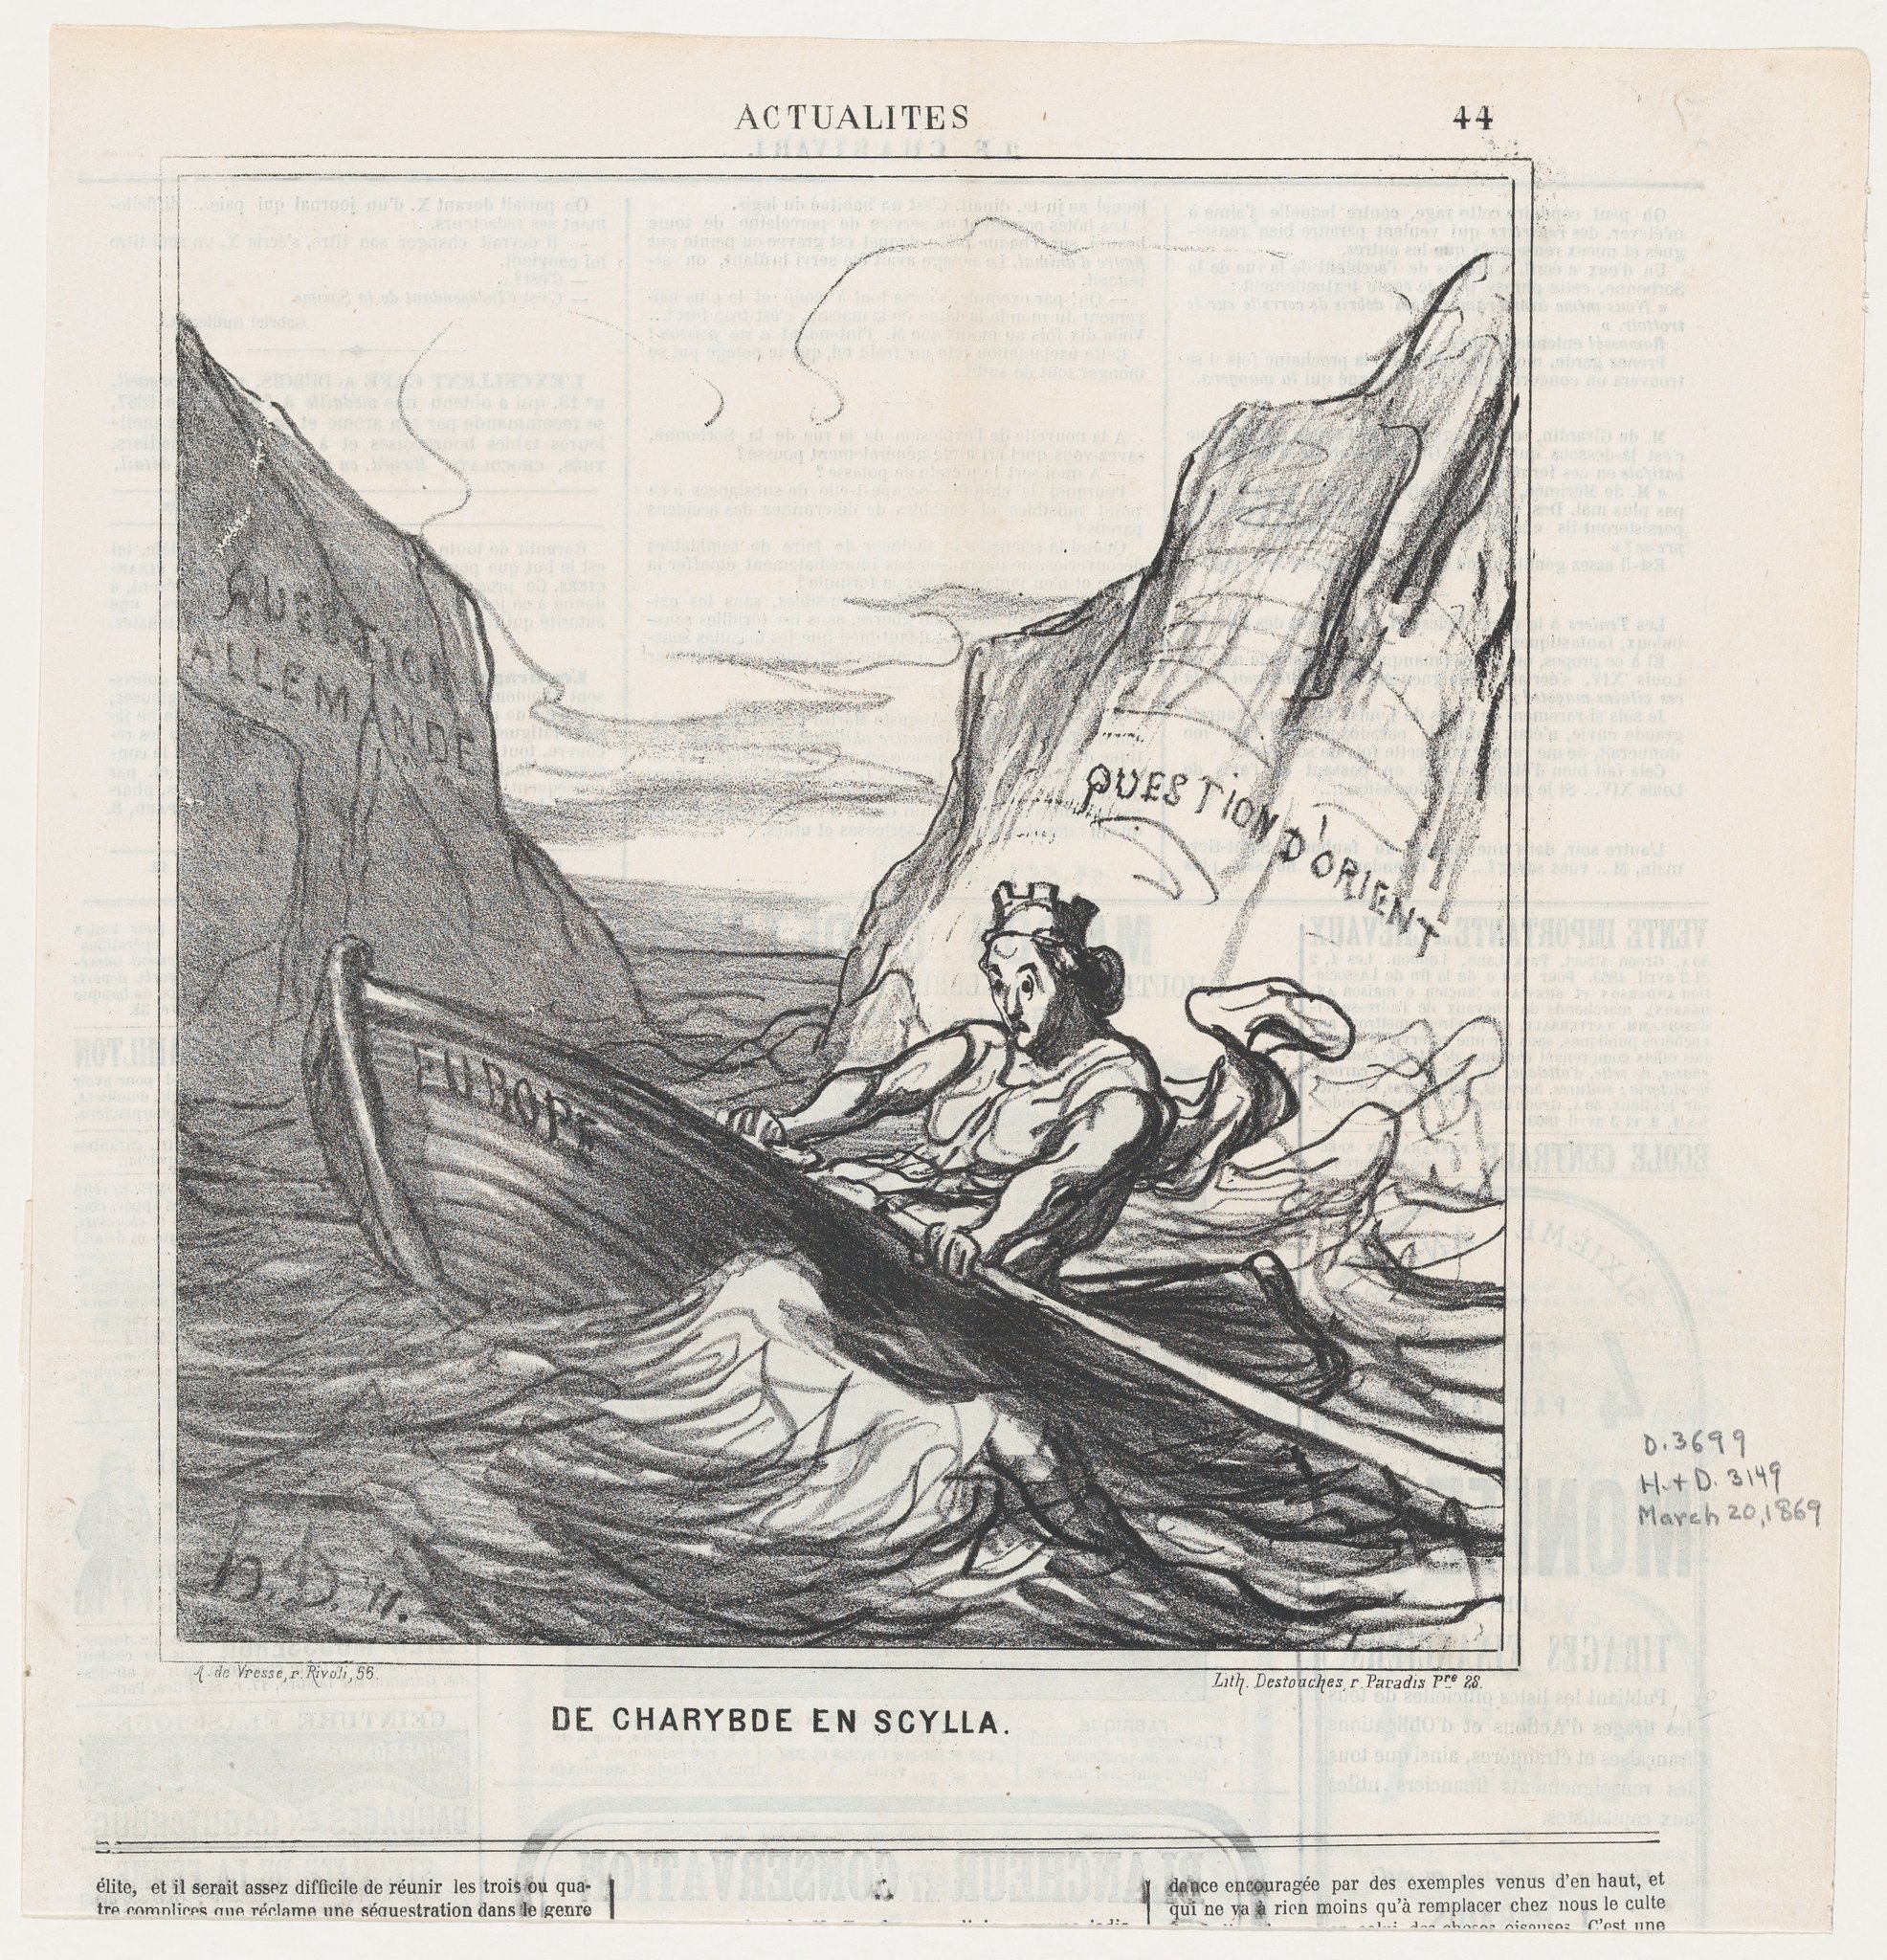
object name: print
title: From Scylla to Charybdis, from 'News of the day,' published in Le Charivari, March 20, 1869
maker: honoré daumier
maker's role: artist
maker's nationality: french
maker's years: 1808-1879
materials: paper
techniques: lithograph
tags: satire,women,boats